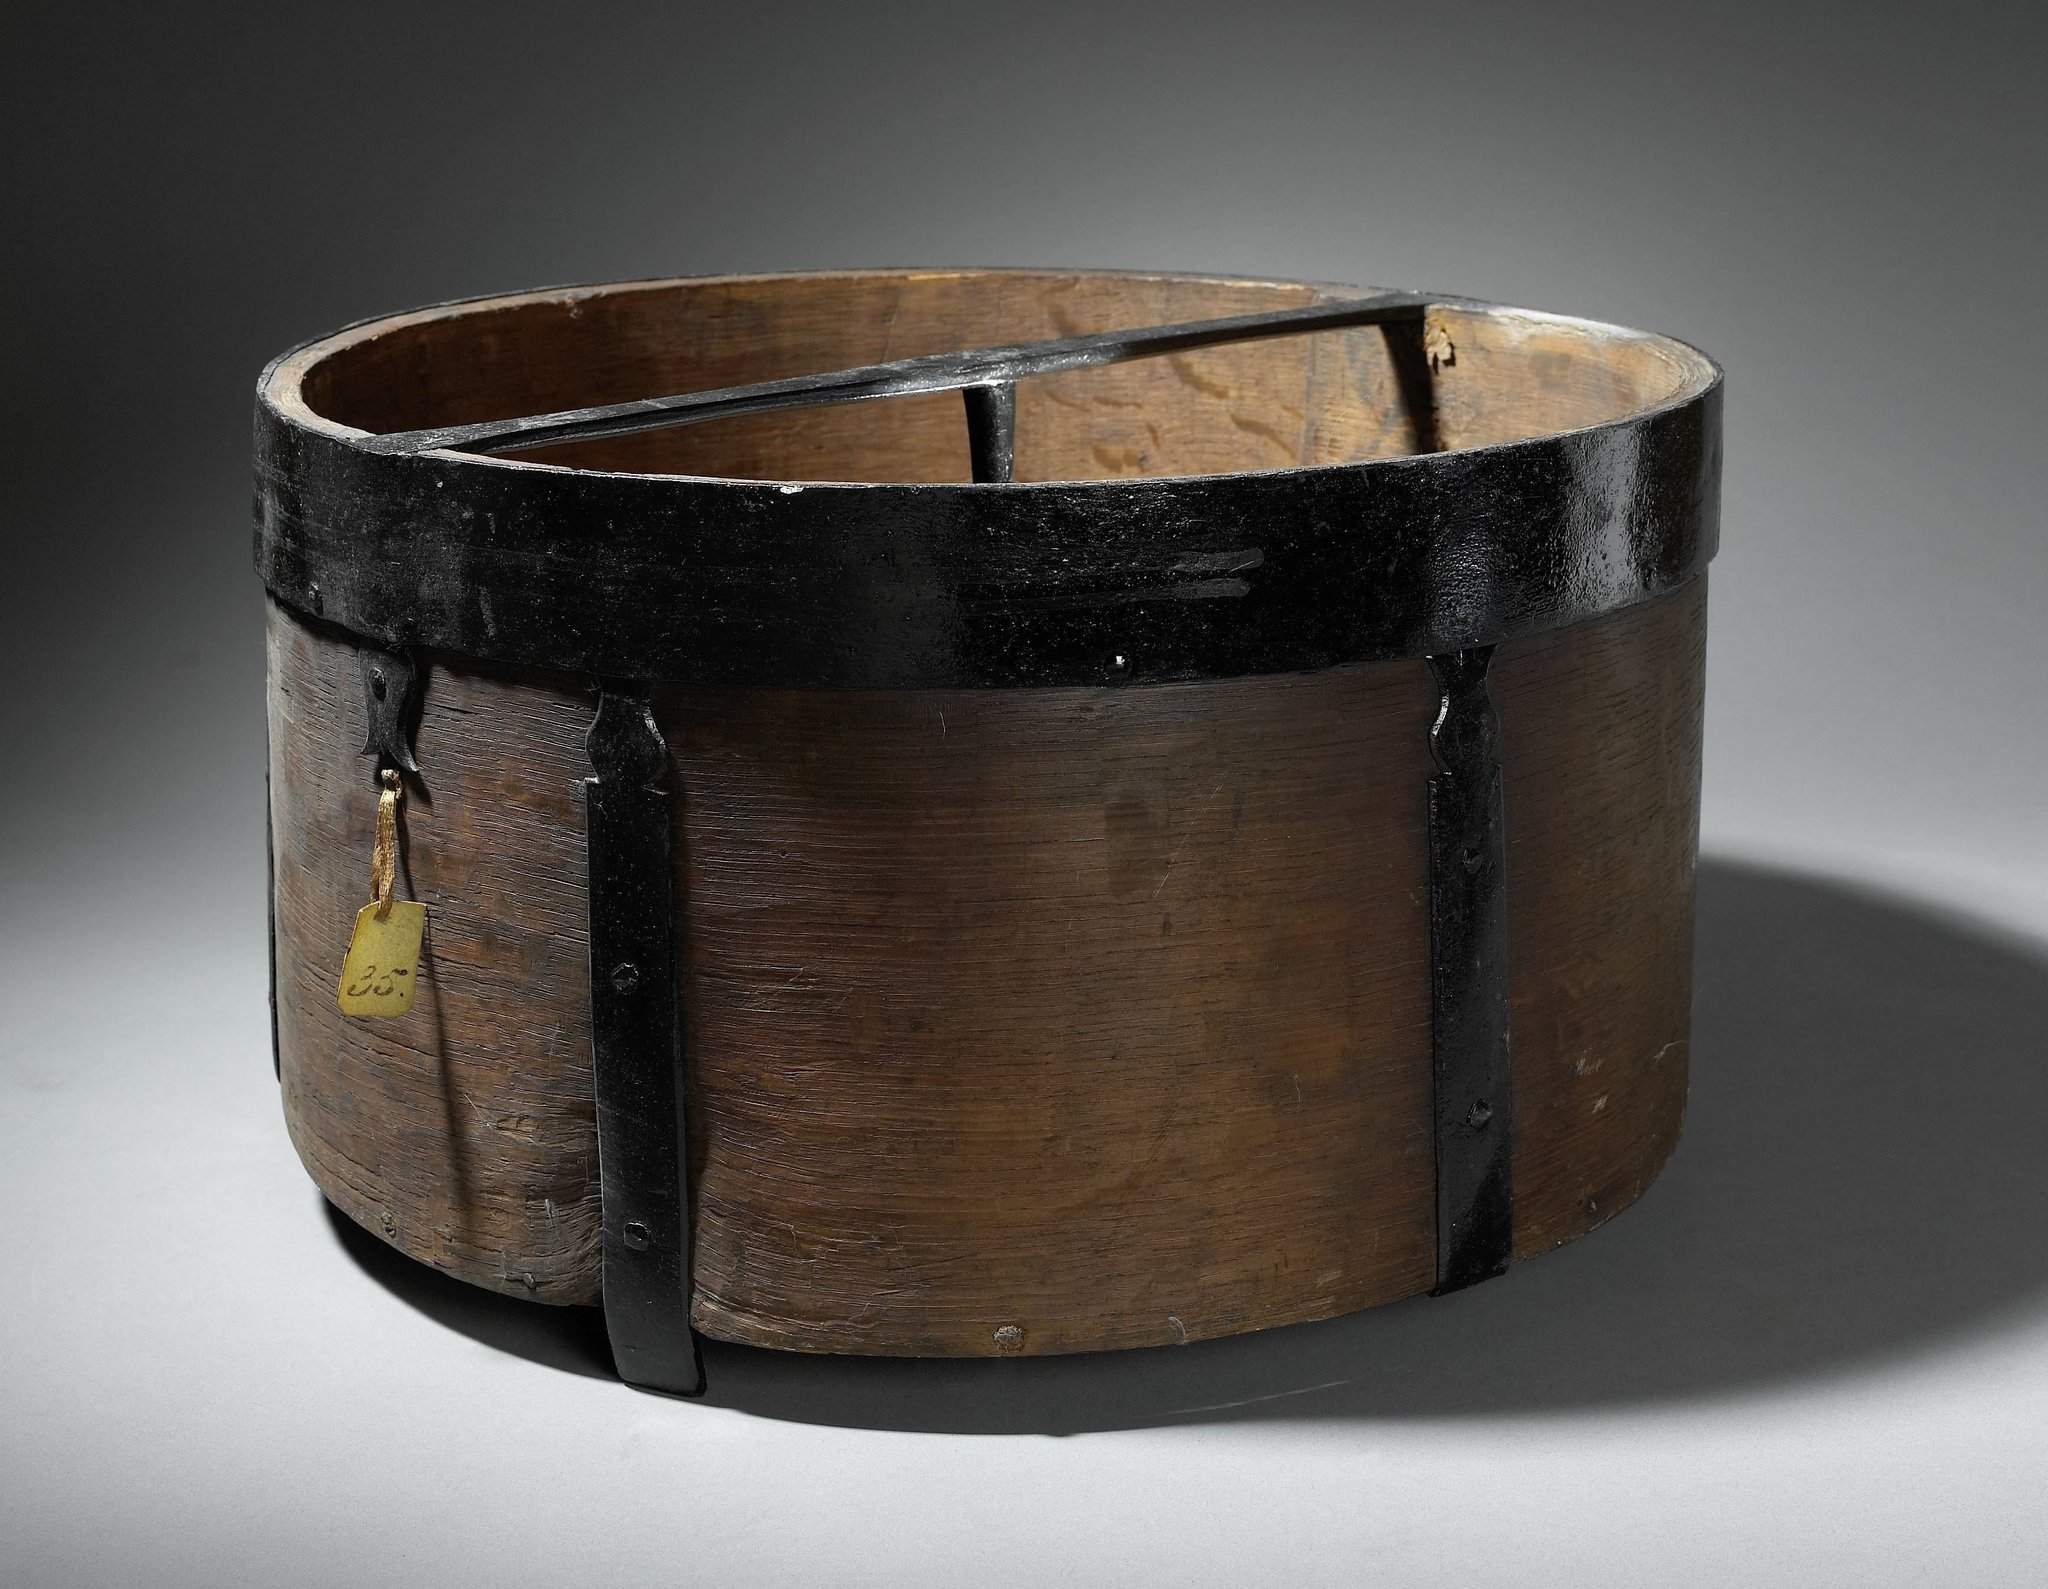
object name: korenmaat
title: 1 Schepel uit Deventer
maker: Anonymous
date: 1800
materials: iron, wood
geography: deventer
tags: deventer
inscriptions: : ‘1800’, number: ‘35’, title: ‘een Boisseau Deventer’, title: ‘een Schepel voor koren en kalk’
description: Spanen en ijzeren inhoudsmaat voor droge waren met brug en stijl van 1 schepel, v.z.v. stempels en etiketten.